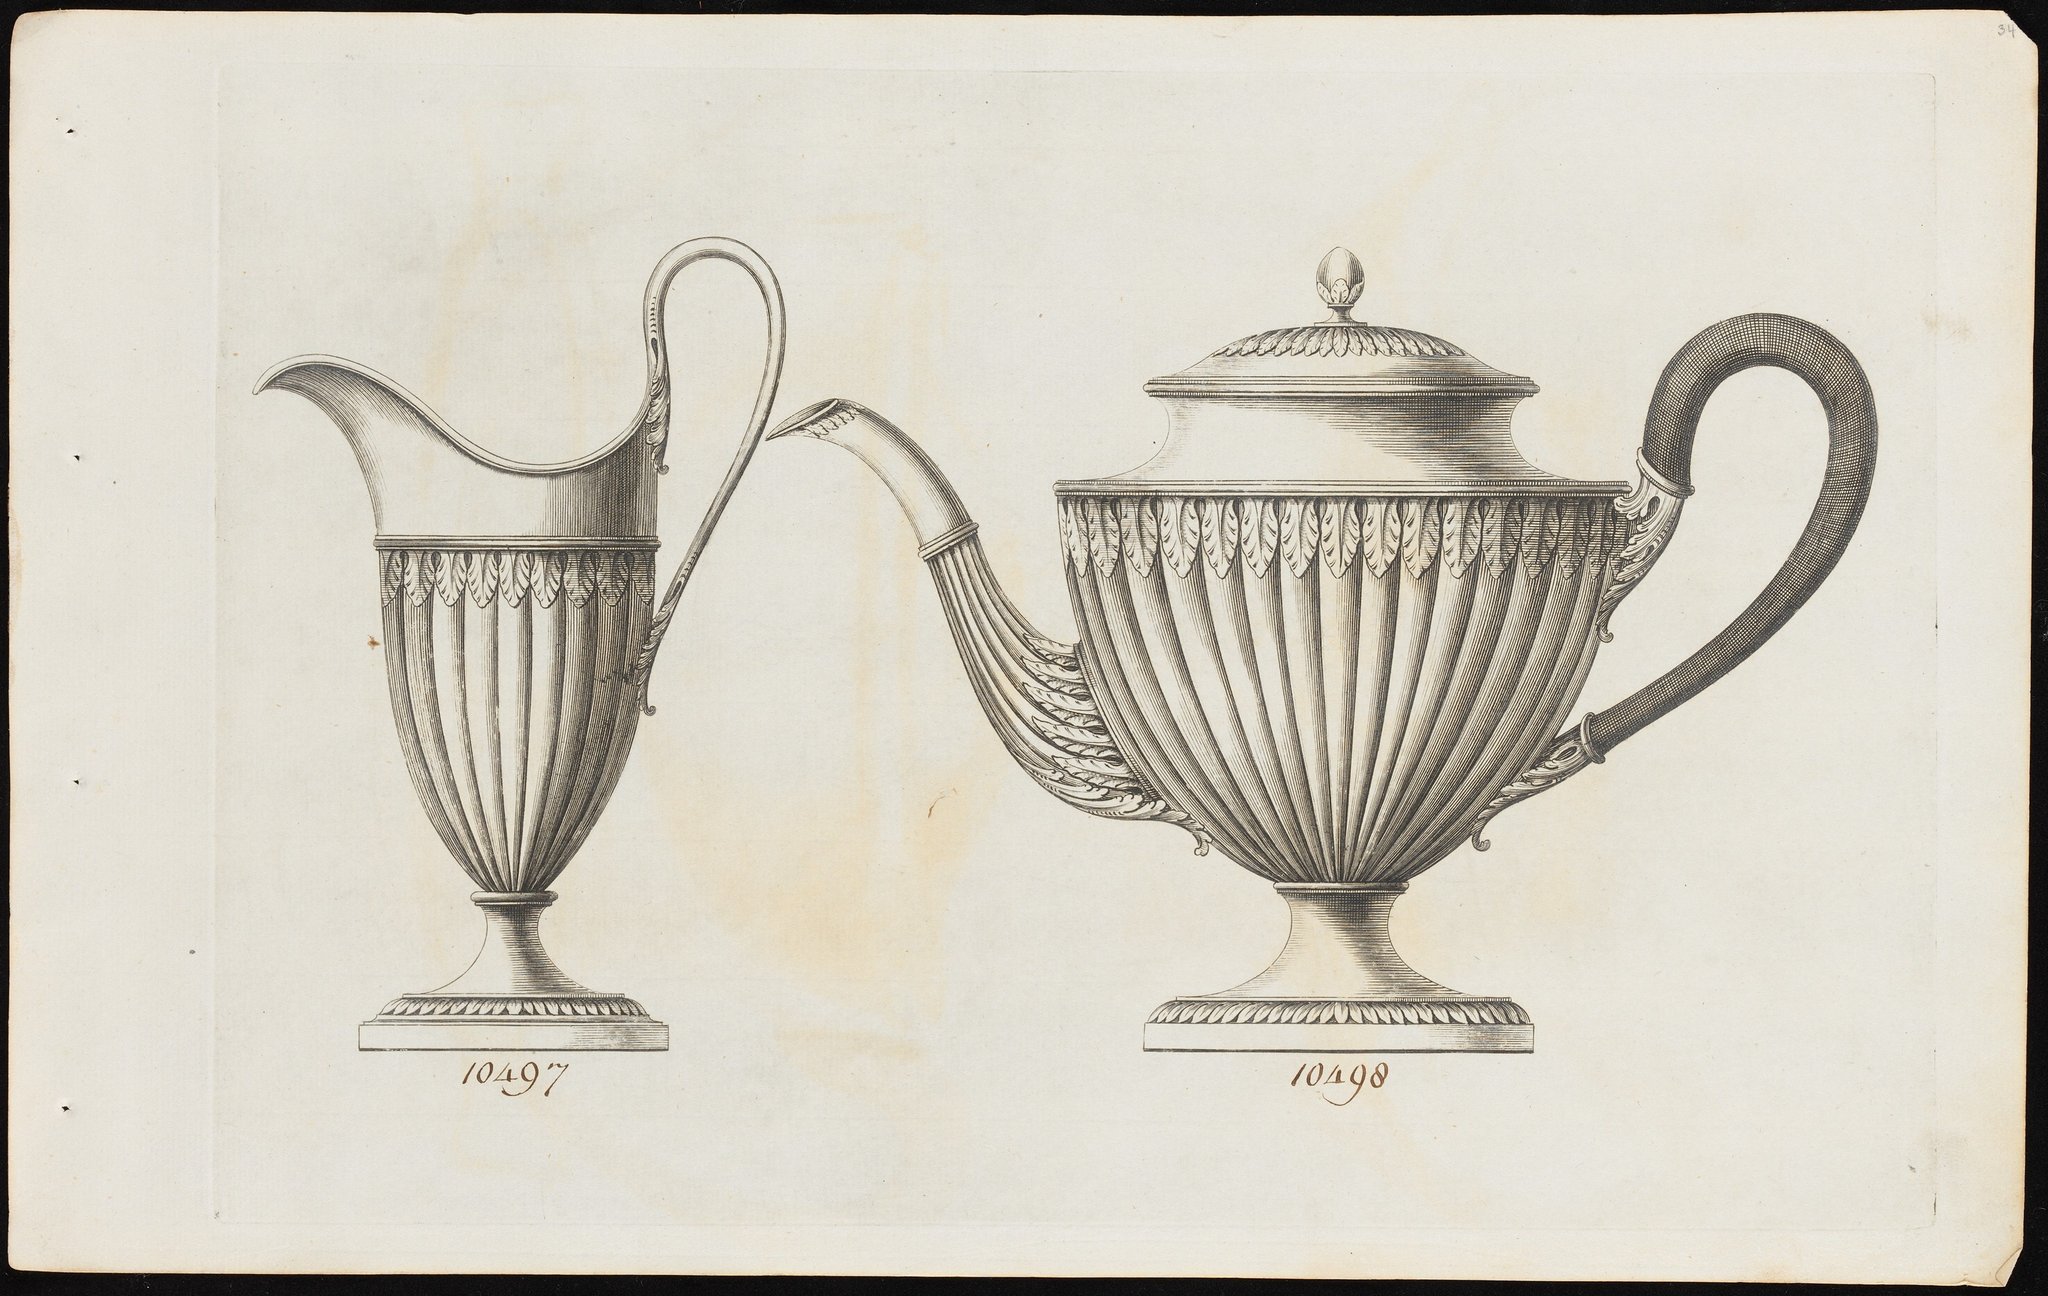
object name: portfolio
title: Manufacturer's Catalogue of Silver Plated Ware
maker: matthew boulton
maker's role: designer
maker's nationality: british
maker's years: 1728-1809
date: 1790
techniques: etching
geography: birmingham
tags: lamps,teapots,urns